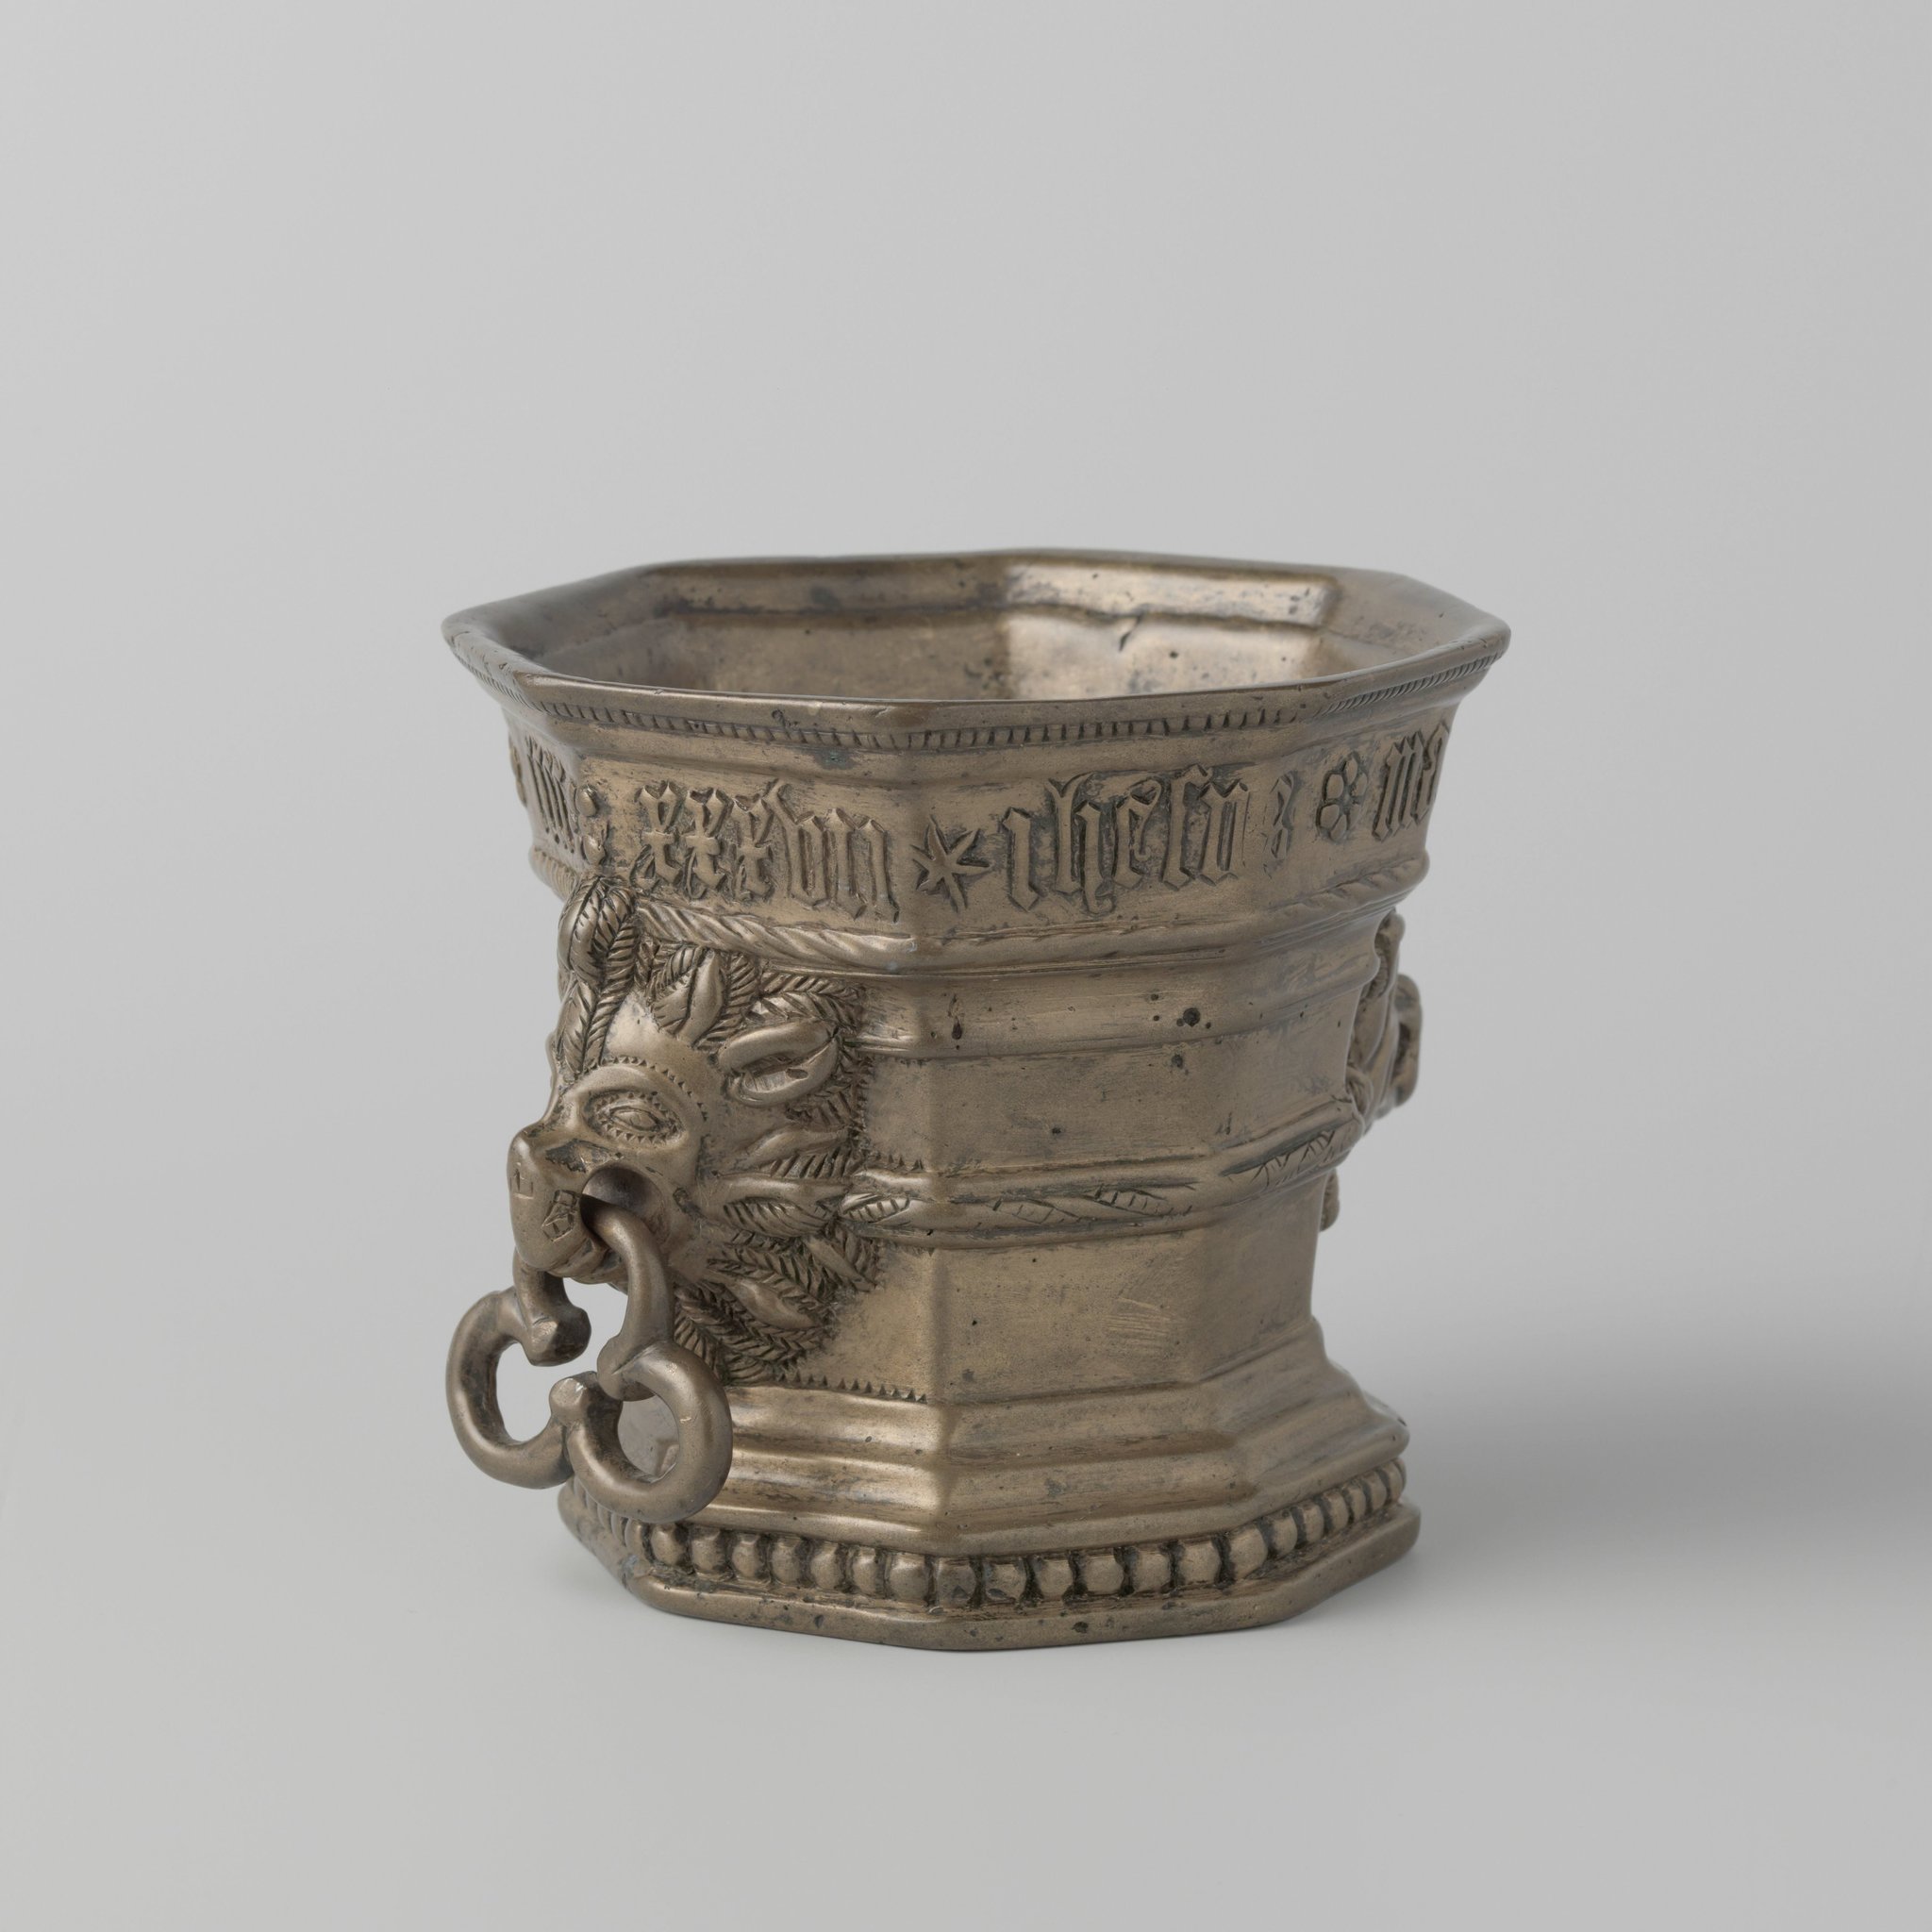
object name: mortar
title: Vijzel met opschrift: jhesus.maria.anno.domini.m.cccc.xxxvii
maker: albert hachmann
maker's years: 1520-1565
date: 1537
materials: bronze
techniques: casting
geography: cleves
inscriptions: inscription: ‘jhesus.maria.anno.domini.m.cccc.xxxvii’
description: Mortar and pestle with inscription: 'jhesus maria anno domini MCCCCXXXVII' Bronze. Cleves, 1537, Albert Hachman (?).